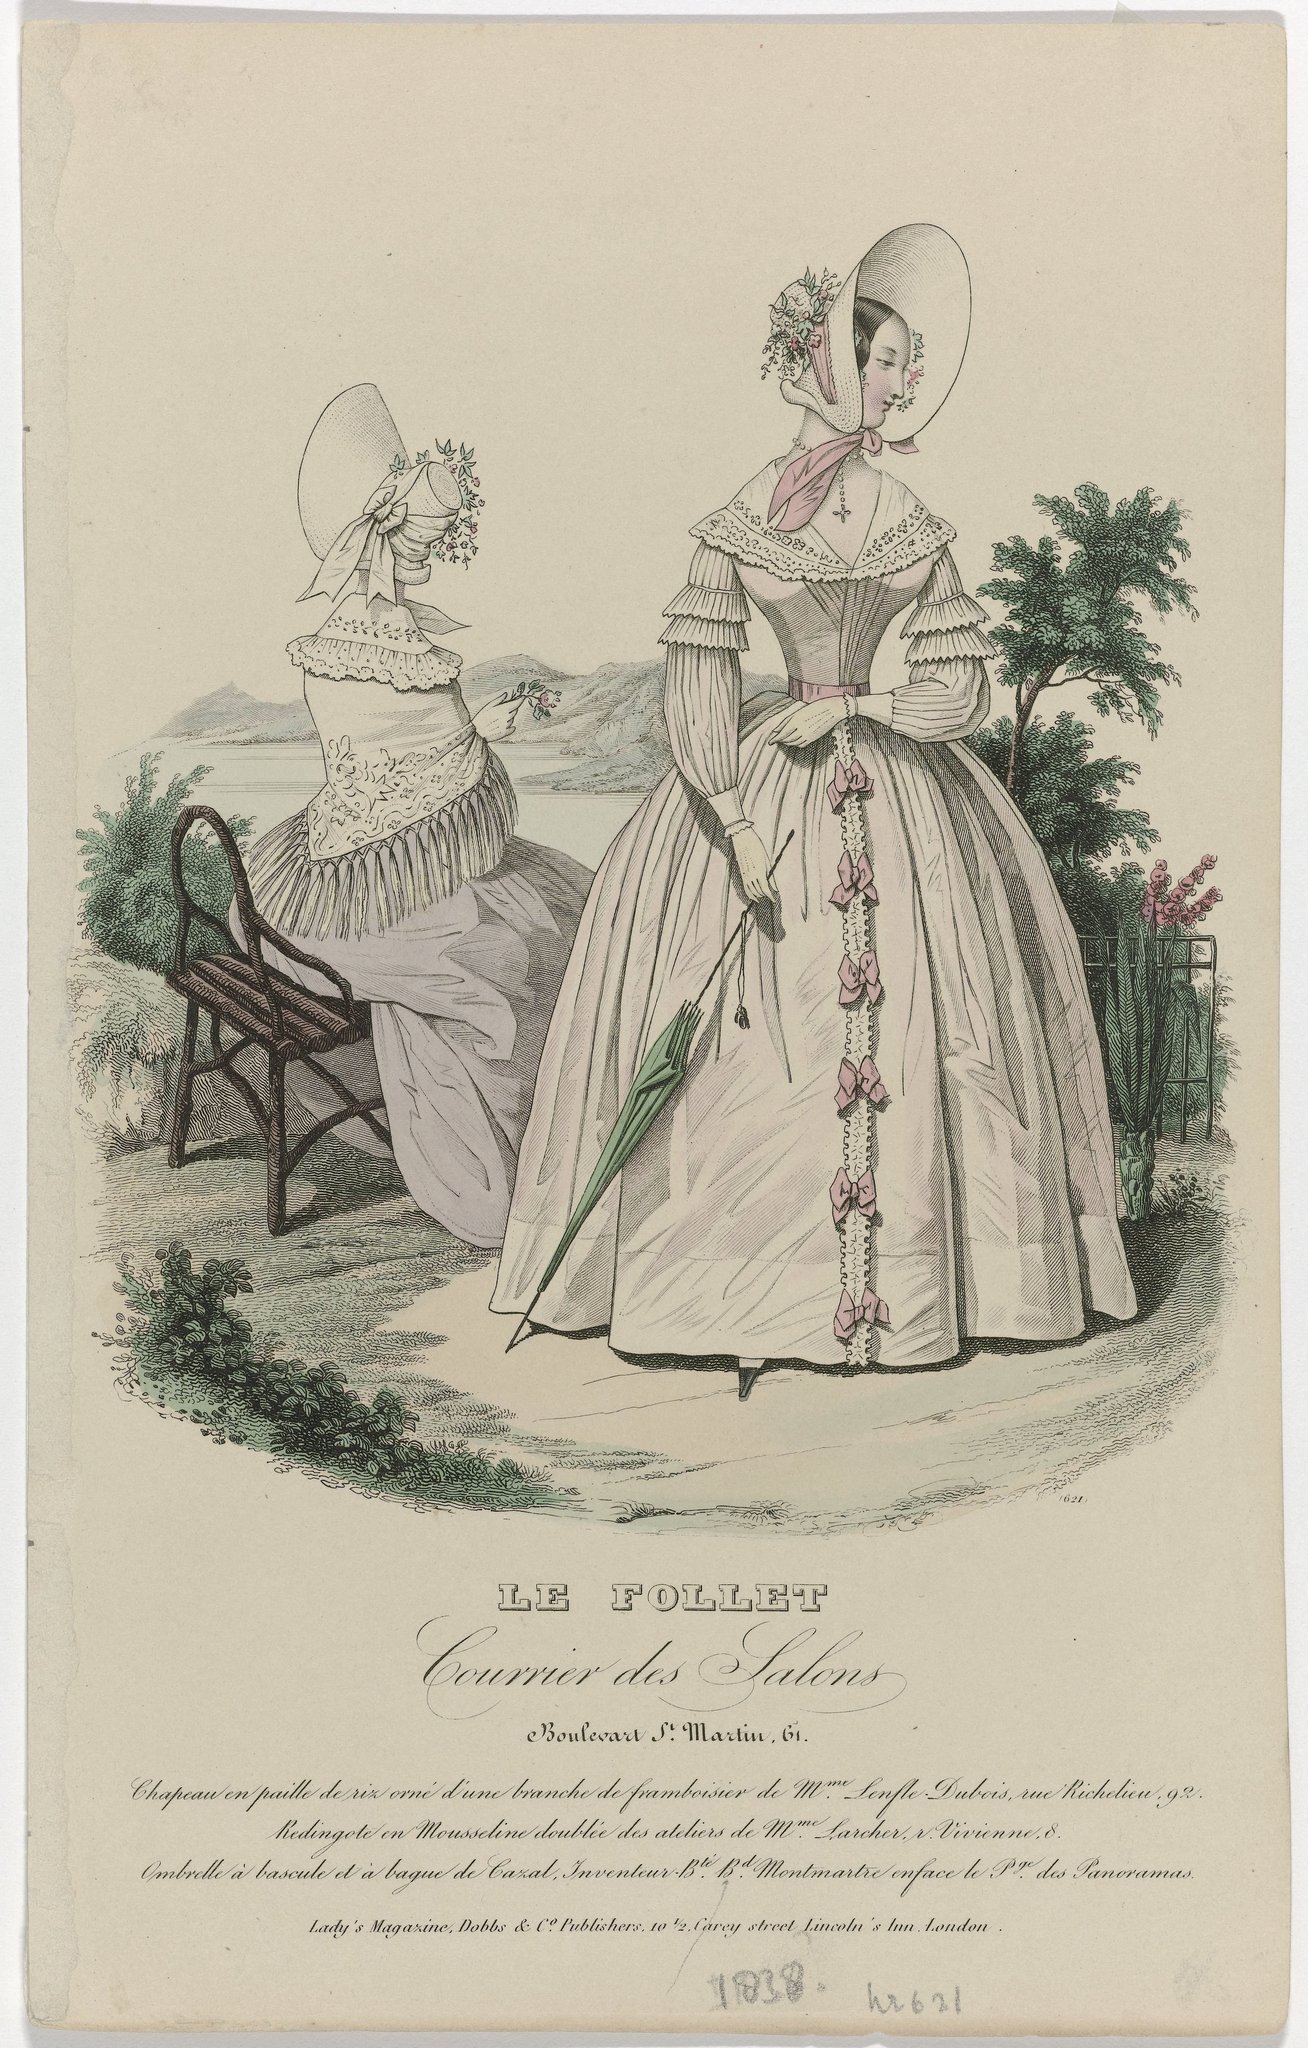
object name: fashion print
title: Le Follet Courrier des Salons, 1838, No. 621: Chapeau en paille de riz (...)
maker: Anonymous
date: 1838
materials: paper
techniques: engraving, hand coloring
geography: london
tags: clothing for the upper part of the body (shawl) (+ women's clothes), dress, gown: redingote (+ women's clothes), fashion plates, head-gear: hat (+ women's clothes), shoes, sandals (+ women's clothes), gloves, mittens, etc. (+ women's clothes), necklace (+ women's clothes), parasol, sunshade (+ women's clothes)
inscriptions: caption: ‘Chapeau en paille de riz ornée d'une branche de framboisier de M.me Lenfle-Dubois, rue Richelieu, 92. Redingote en Mousseline doublée des ateliers de M.me Larcher, r. Vivienne, 8. Ombrelle à bascule et à bague de Cazal, Inventeur-B.té B.d Montmartre enface le P.ge des Panoramas.’, address: ‘Boulevart S.t Martin, 61. / Lady's Magazine, Dobbs & Co. Publishers, 10 1/2 Carey street Lincoln 's Inn London’, title: ‘Le Follet Courrier des Salons.’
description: Twee vrouwen in een landschap, van wie één op de rug gezien. Volgens het onderschrift: hoed van 'paille de riz' versierd met een tak van de frambozenstruik, van Lenfle-Dubois. Redingote van gevoerde mousseline van de ateliers van Larcher. Parasol met springveer van Cazal, uitvinder, gepatenteerd. Prent uit het modetijdschrift Le Follet Courrier des Salons (novembre 1829- octobre 1882).